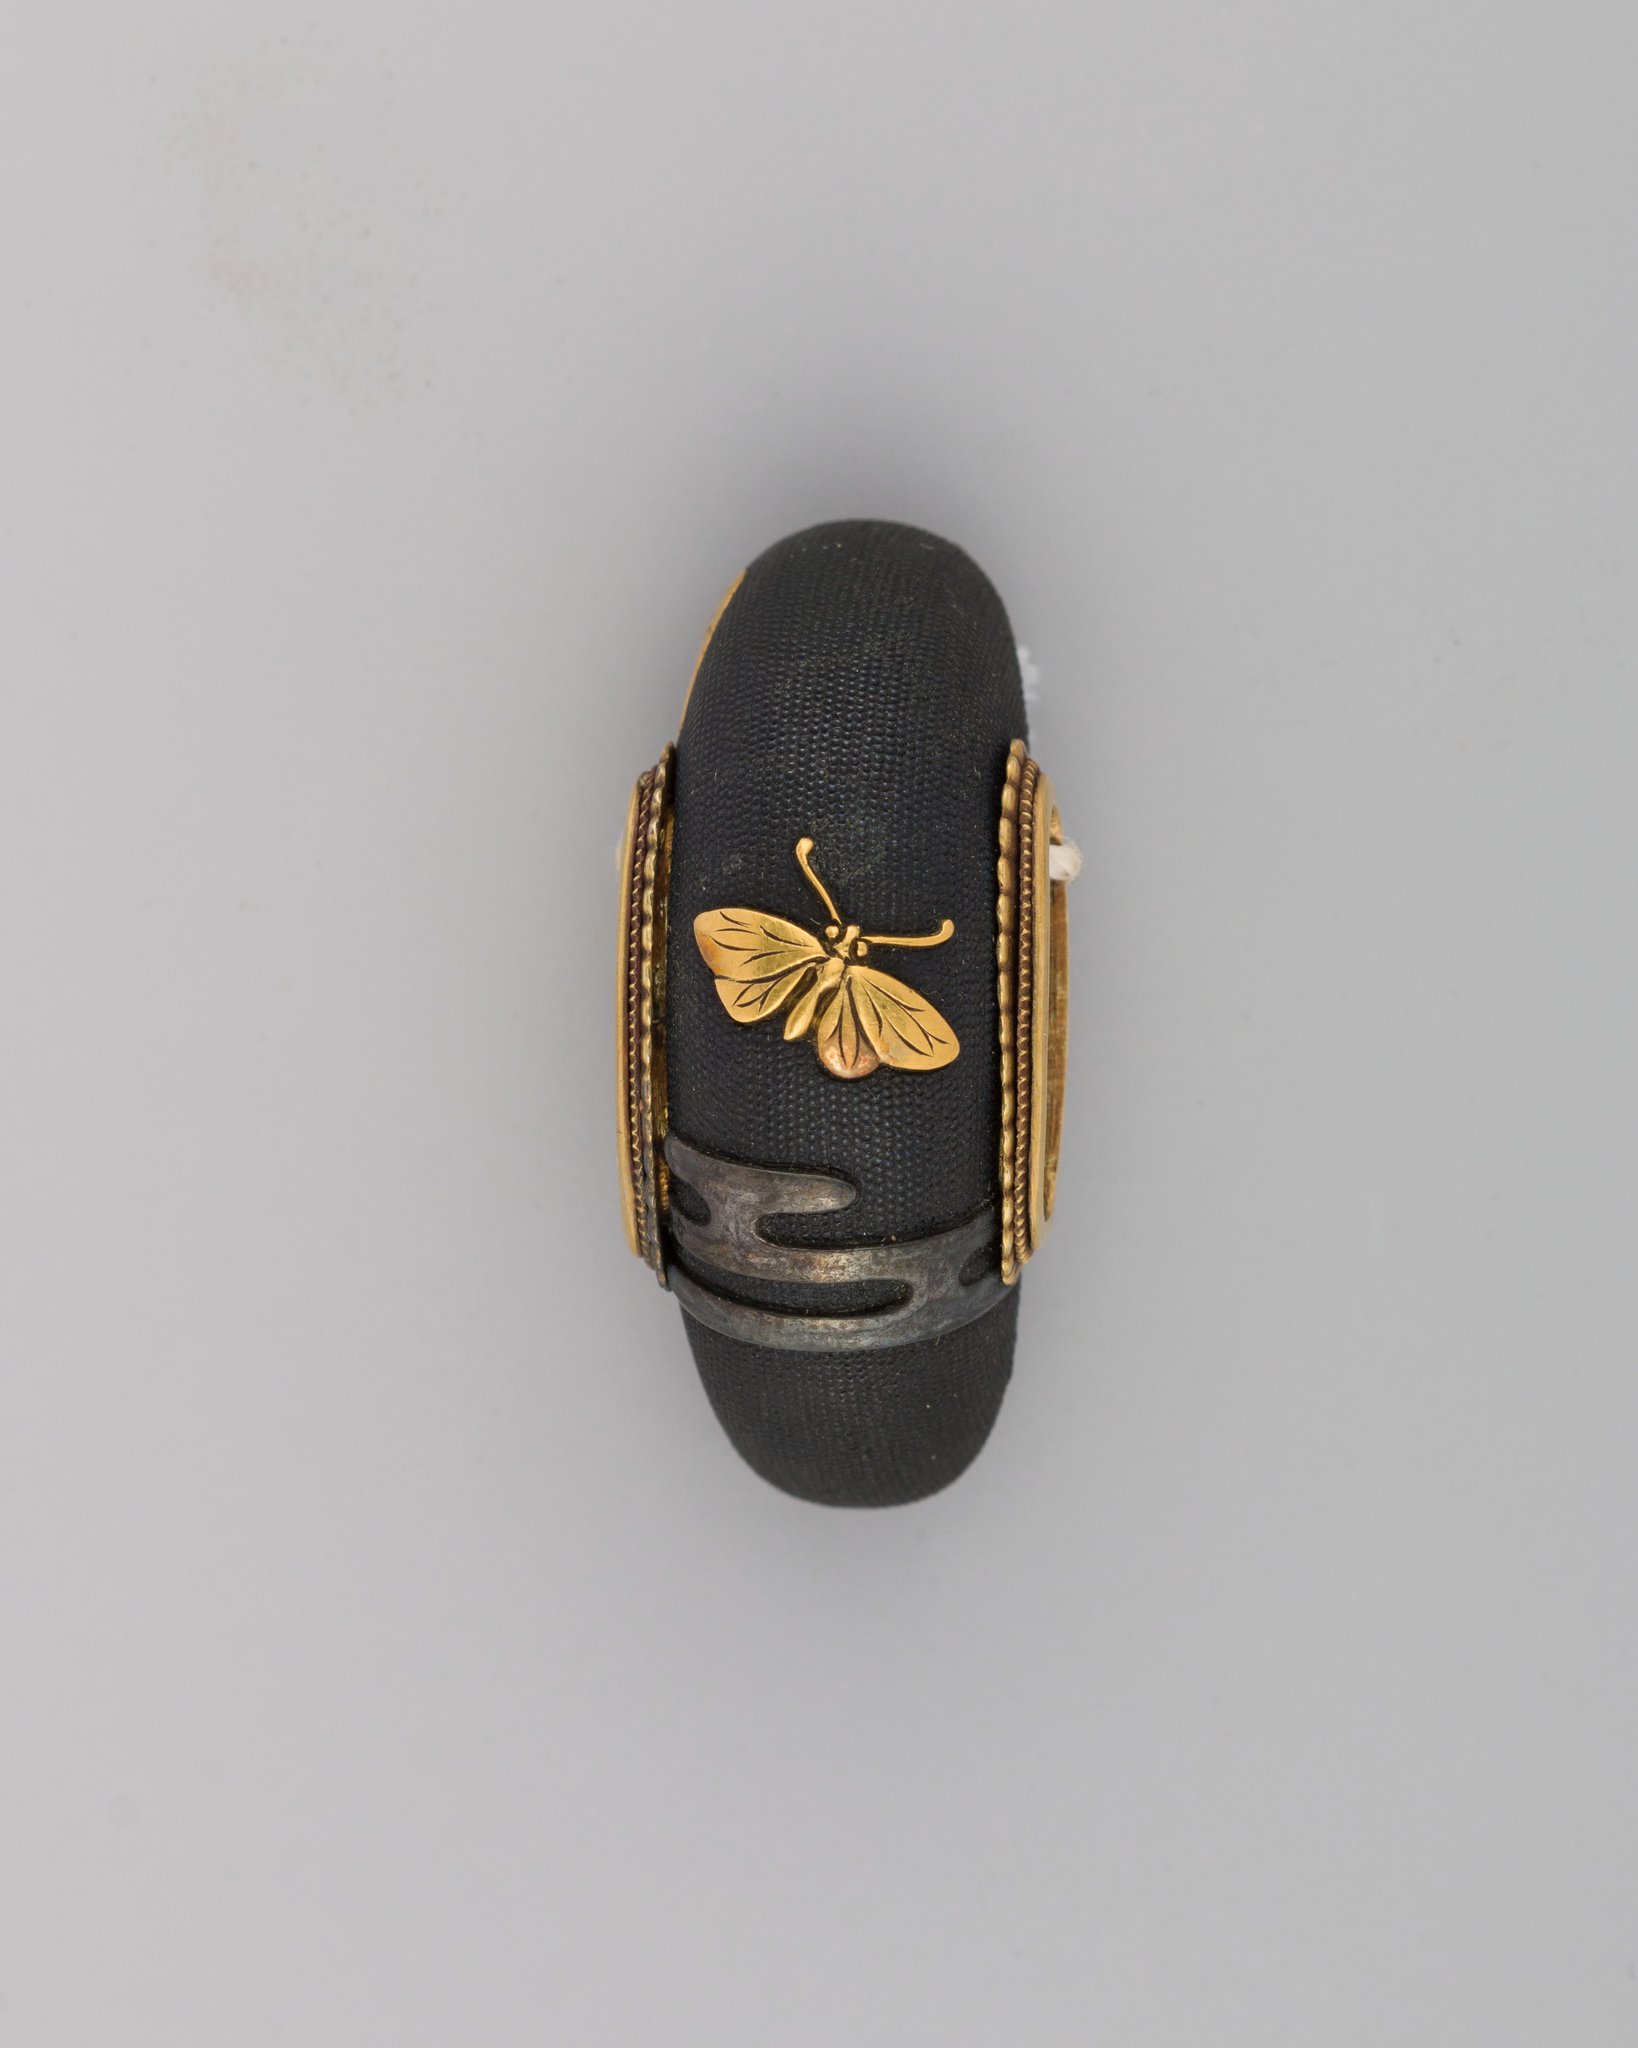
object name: cord knob kurigata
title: Cord Knob (Kurigata)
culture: japanese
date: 1801-1900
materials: gold alloy, gold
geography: japan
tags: butterflies